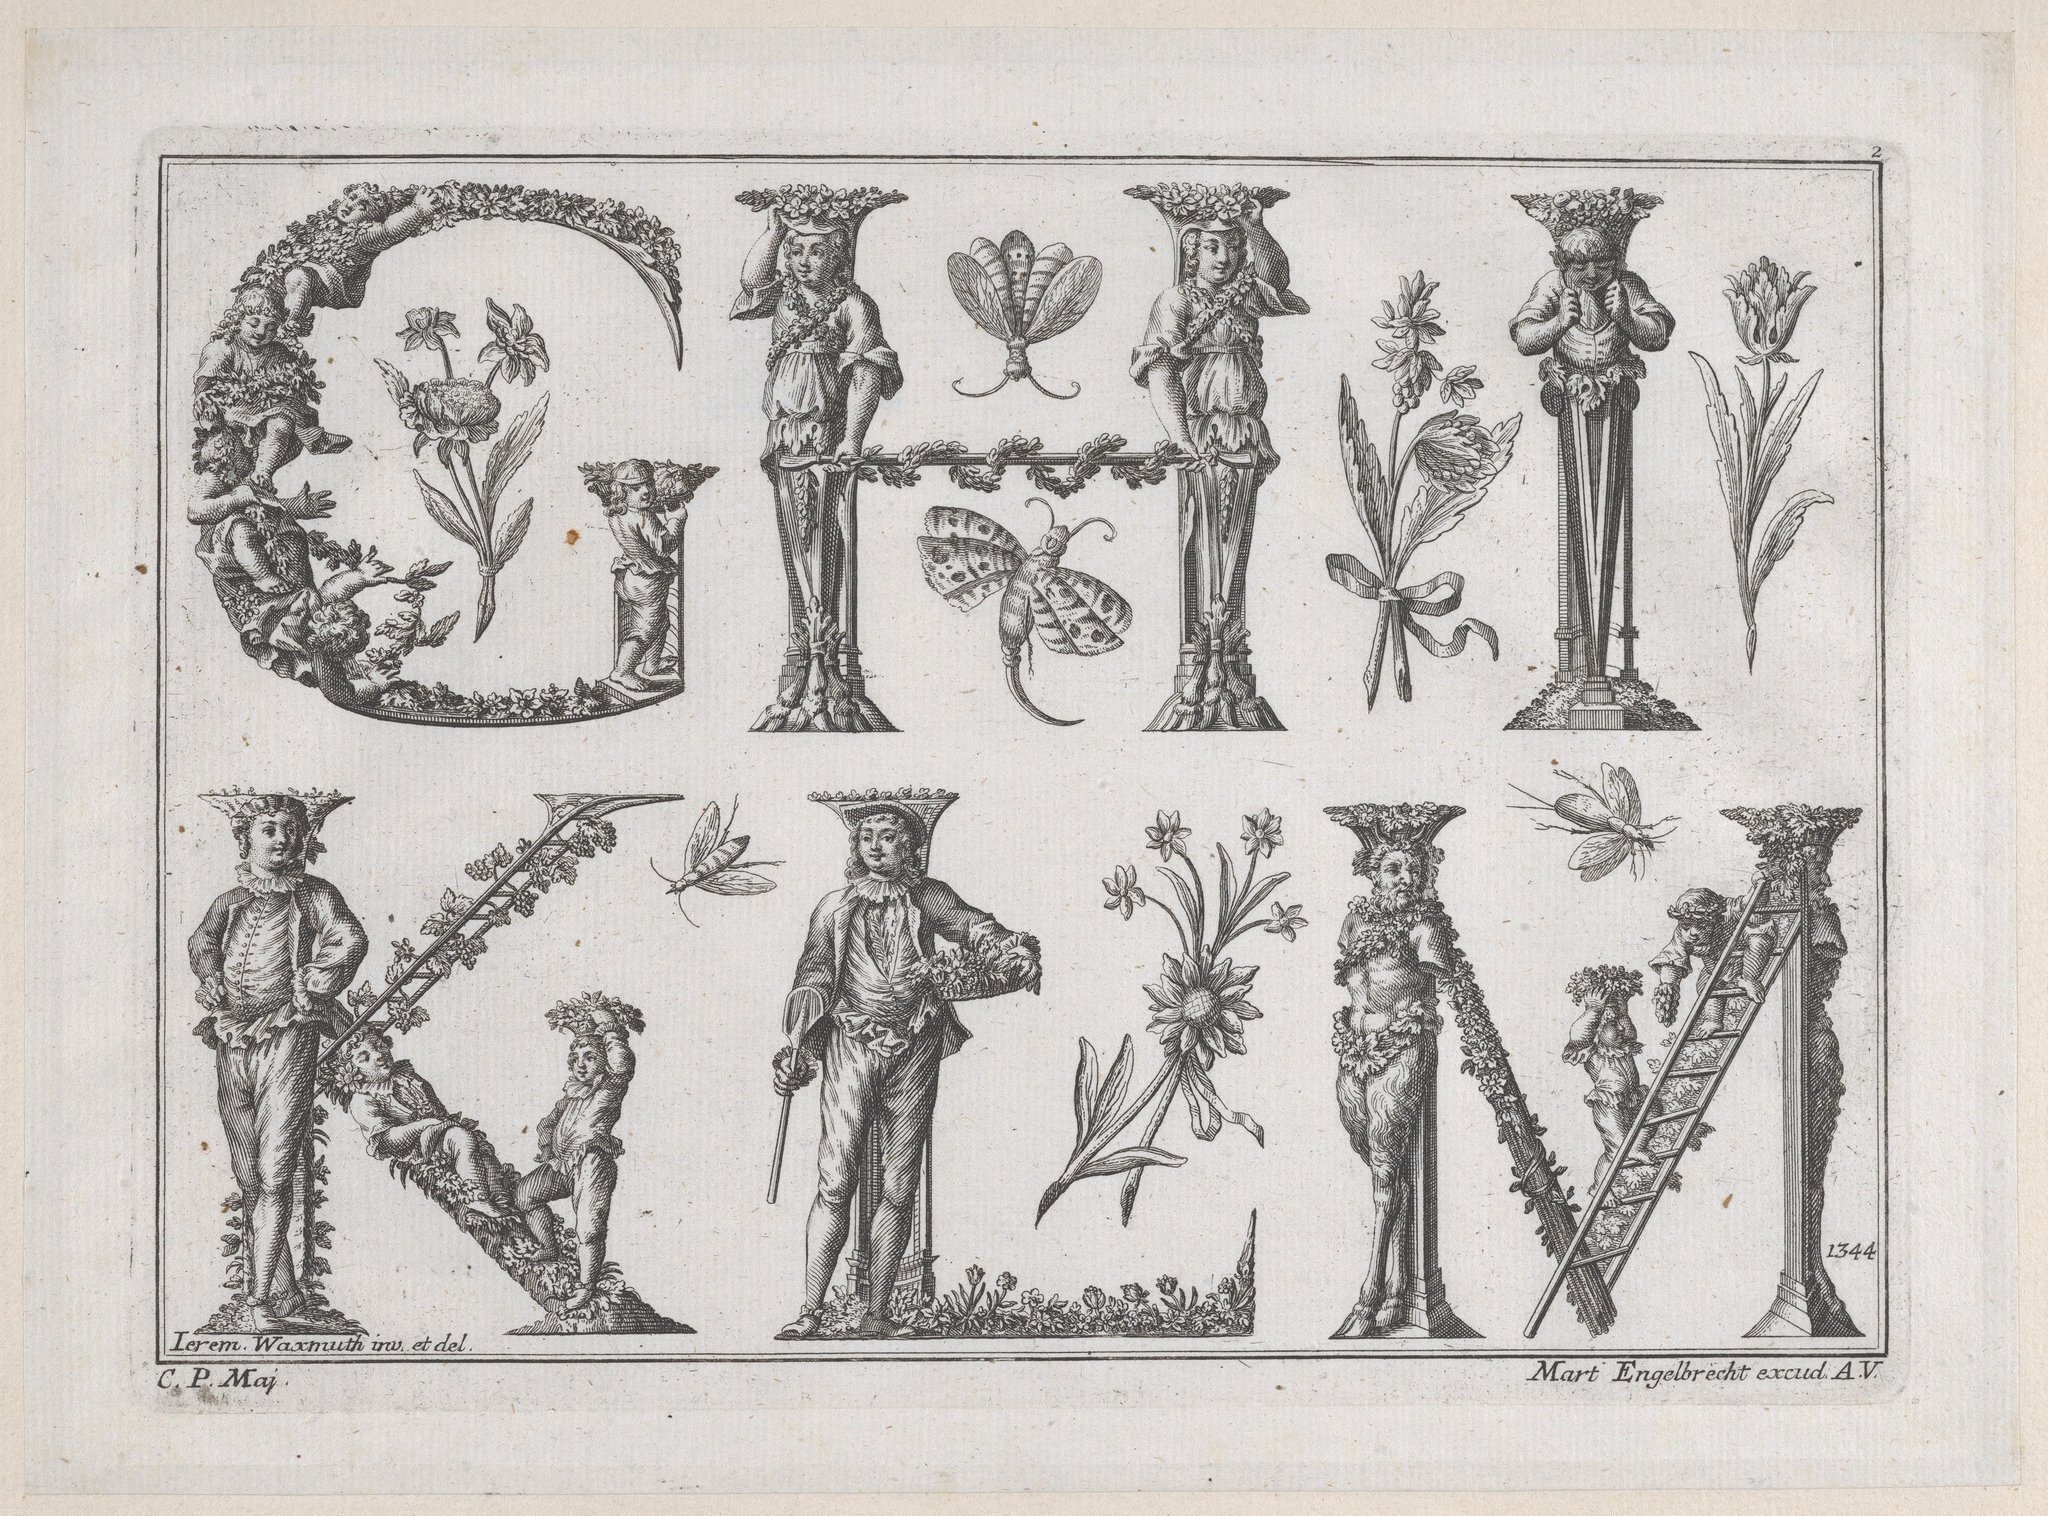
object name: print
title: Decorated Roman alphabet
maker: jeremias wachsmuth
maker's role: artist and engraver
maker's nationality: german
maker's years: 1712-1771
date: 1701-1800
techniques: engraving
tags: men,women,insects,flowers